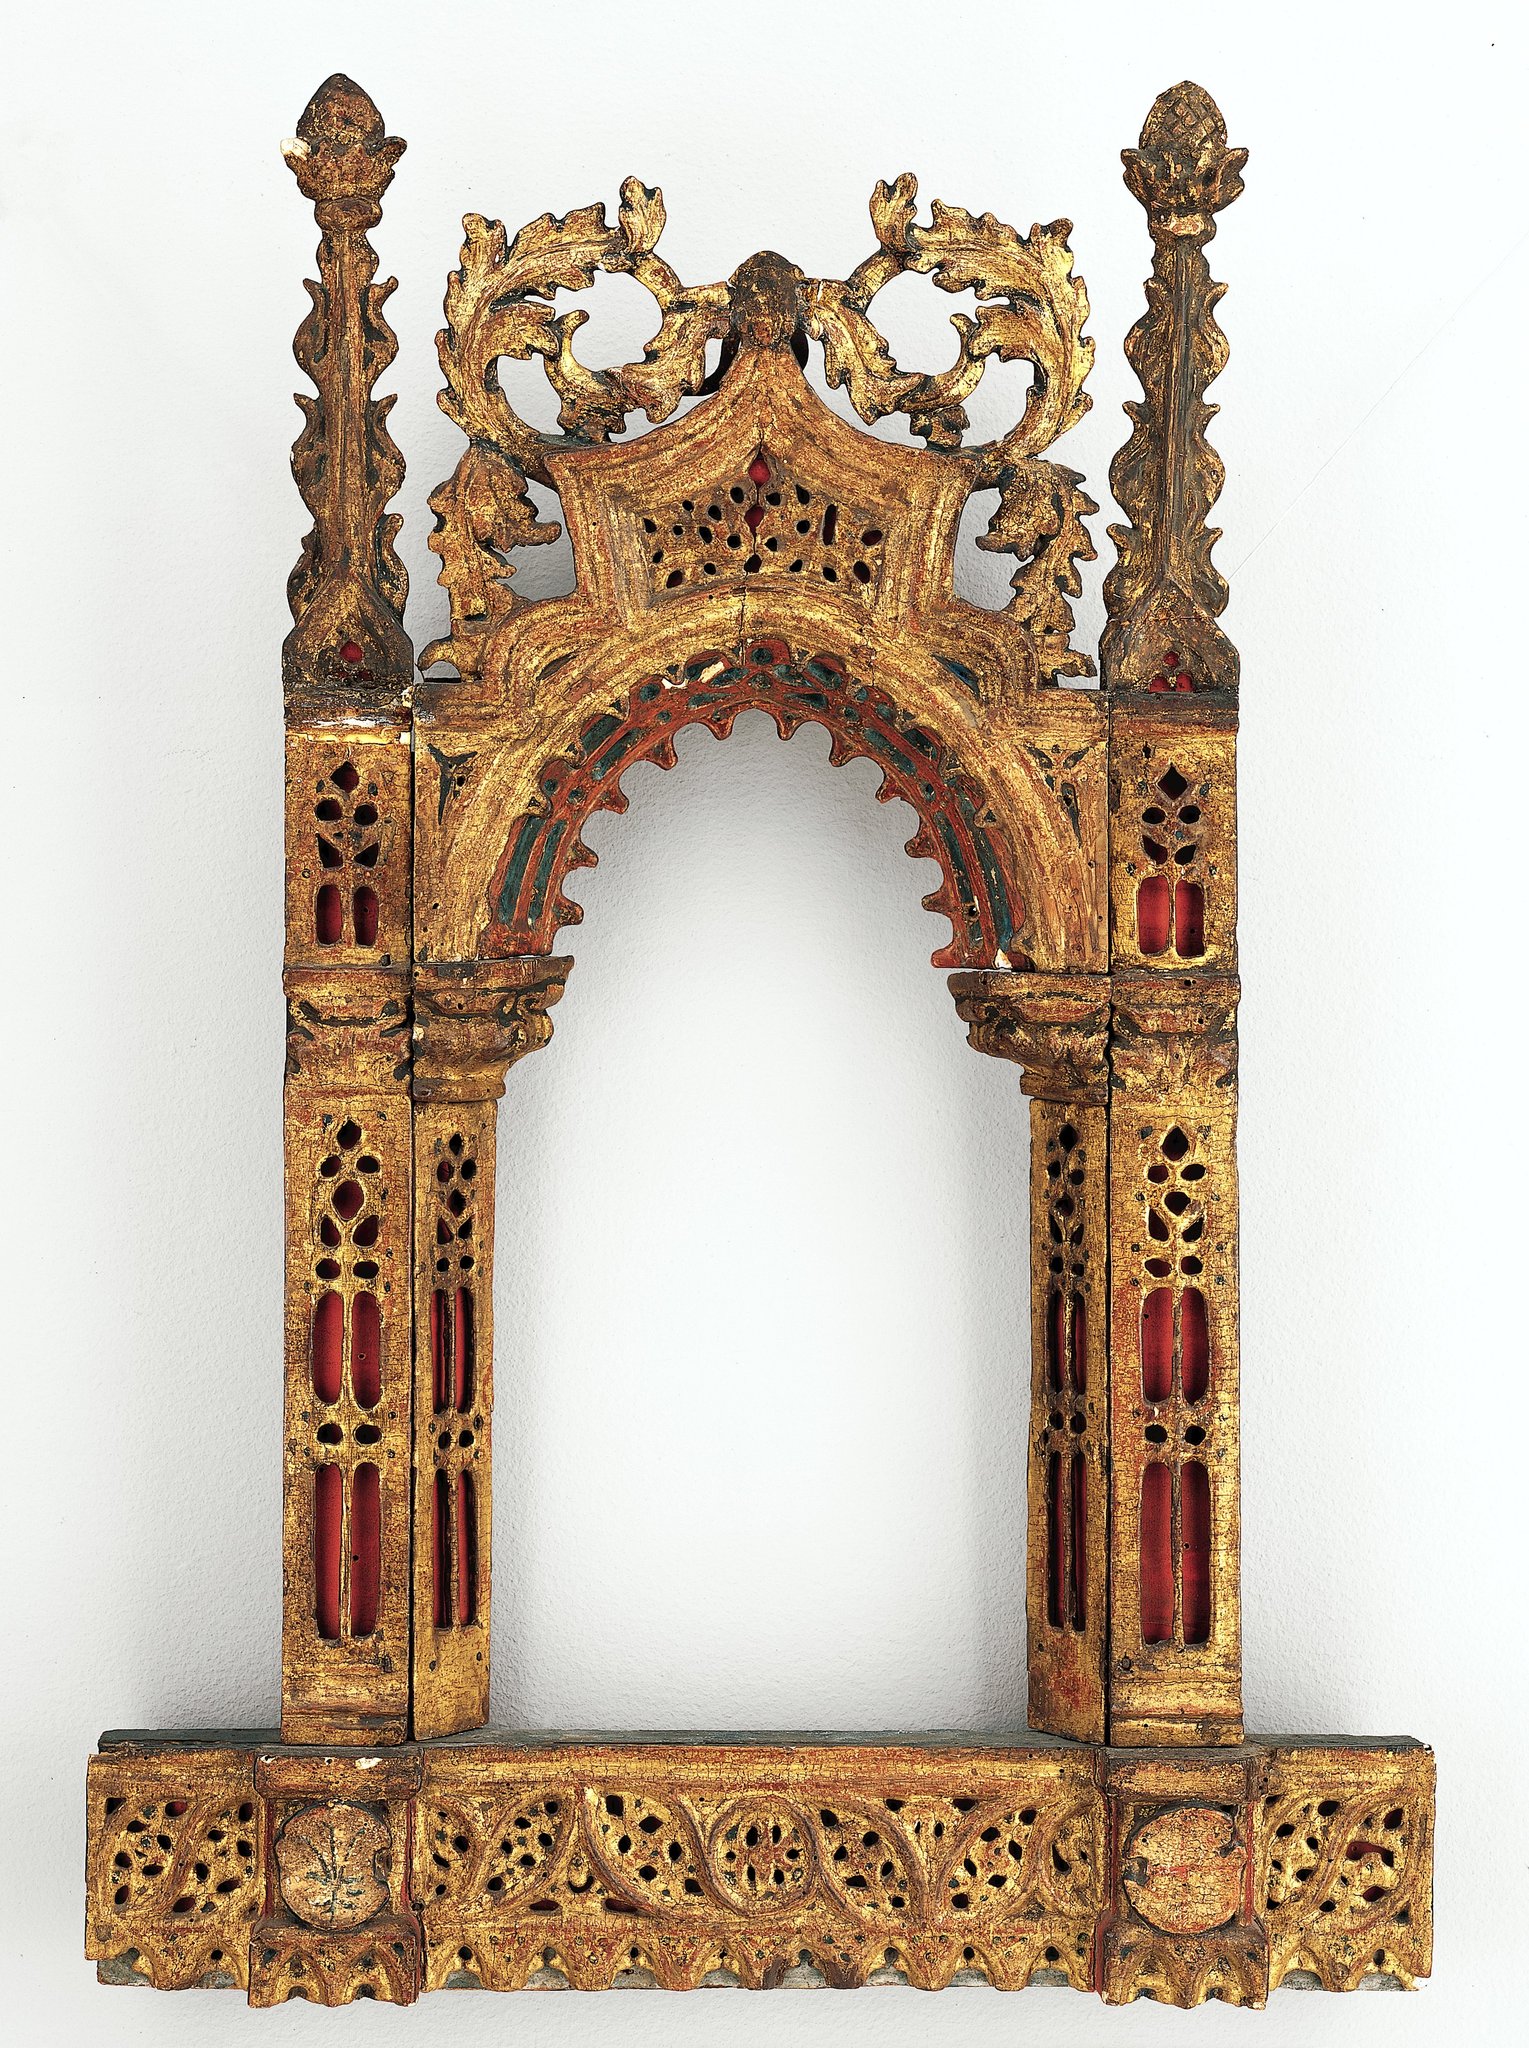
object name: frame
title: Fragment of an altarpiece frame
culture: italian, veneto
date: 1450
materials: wood